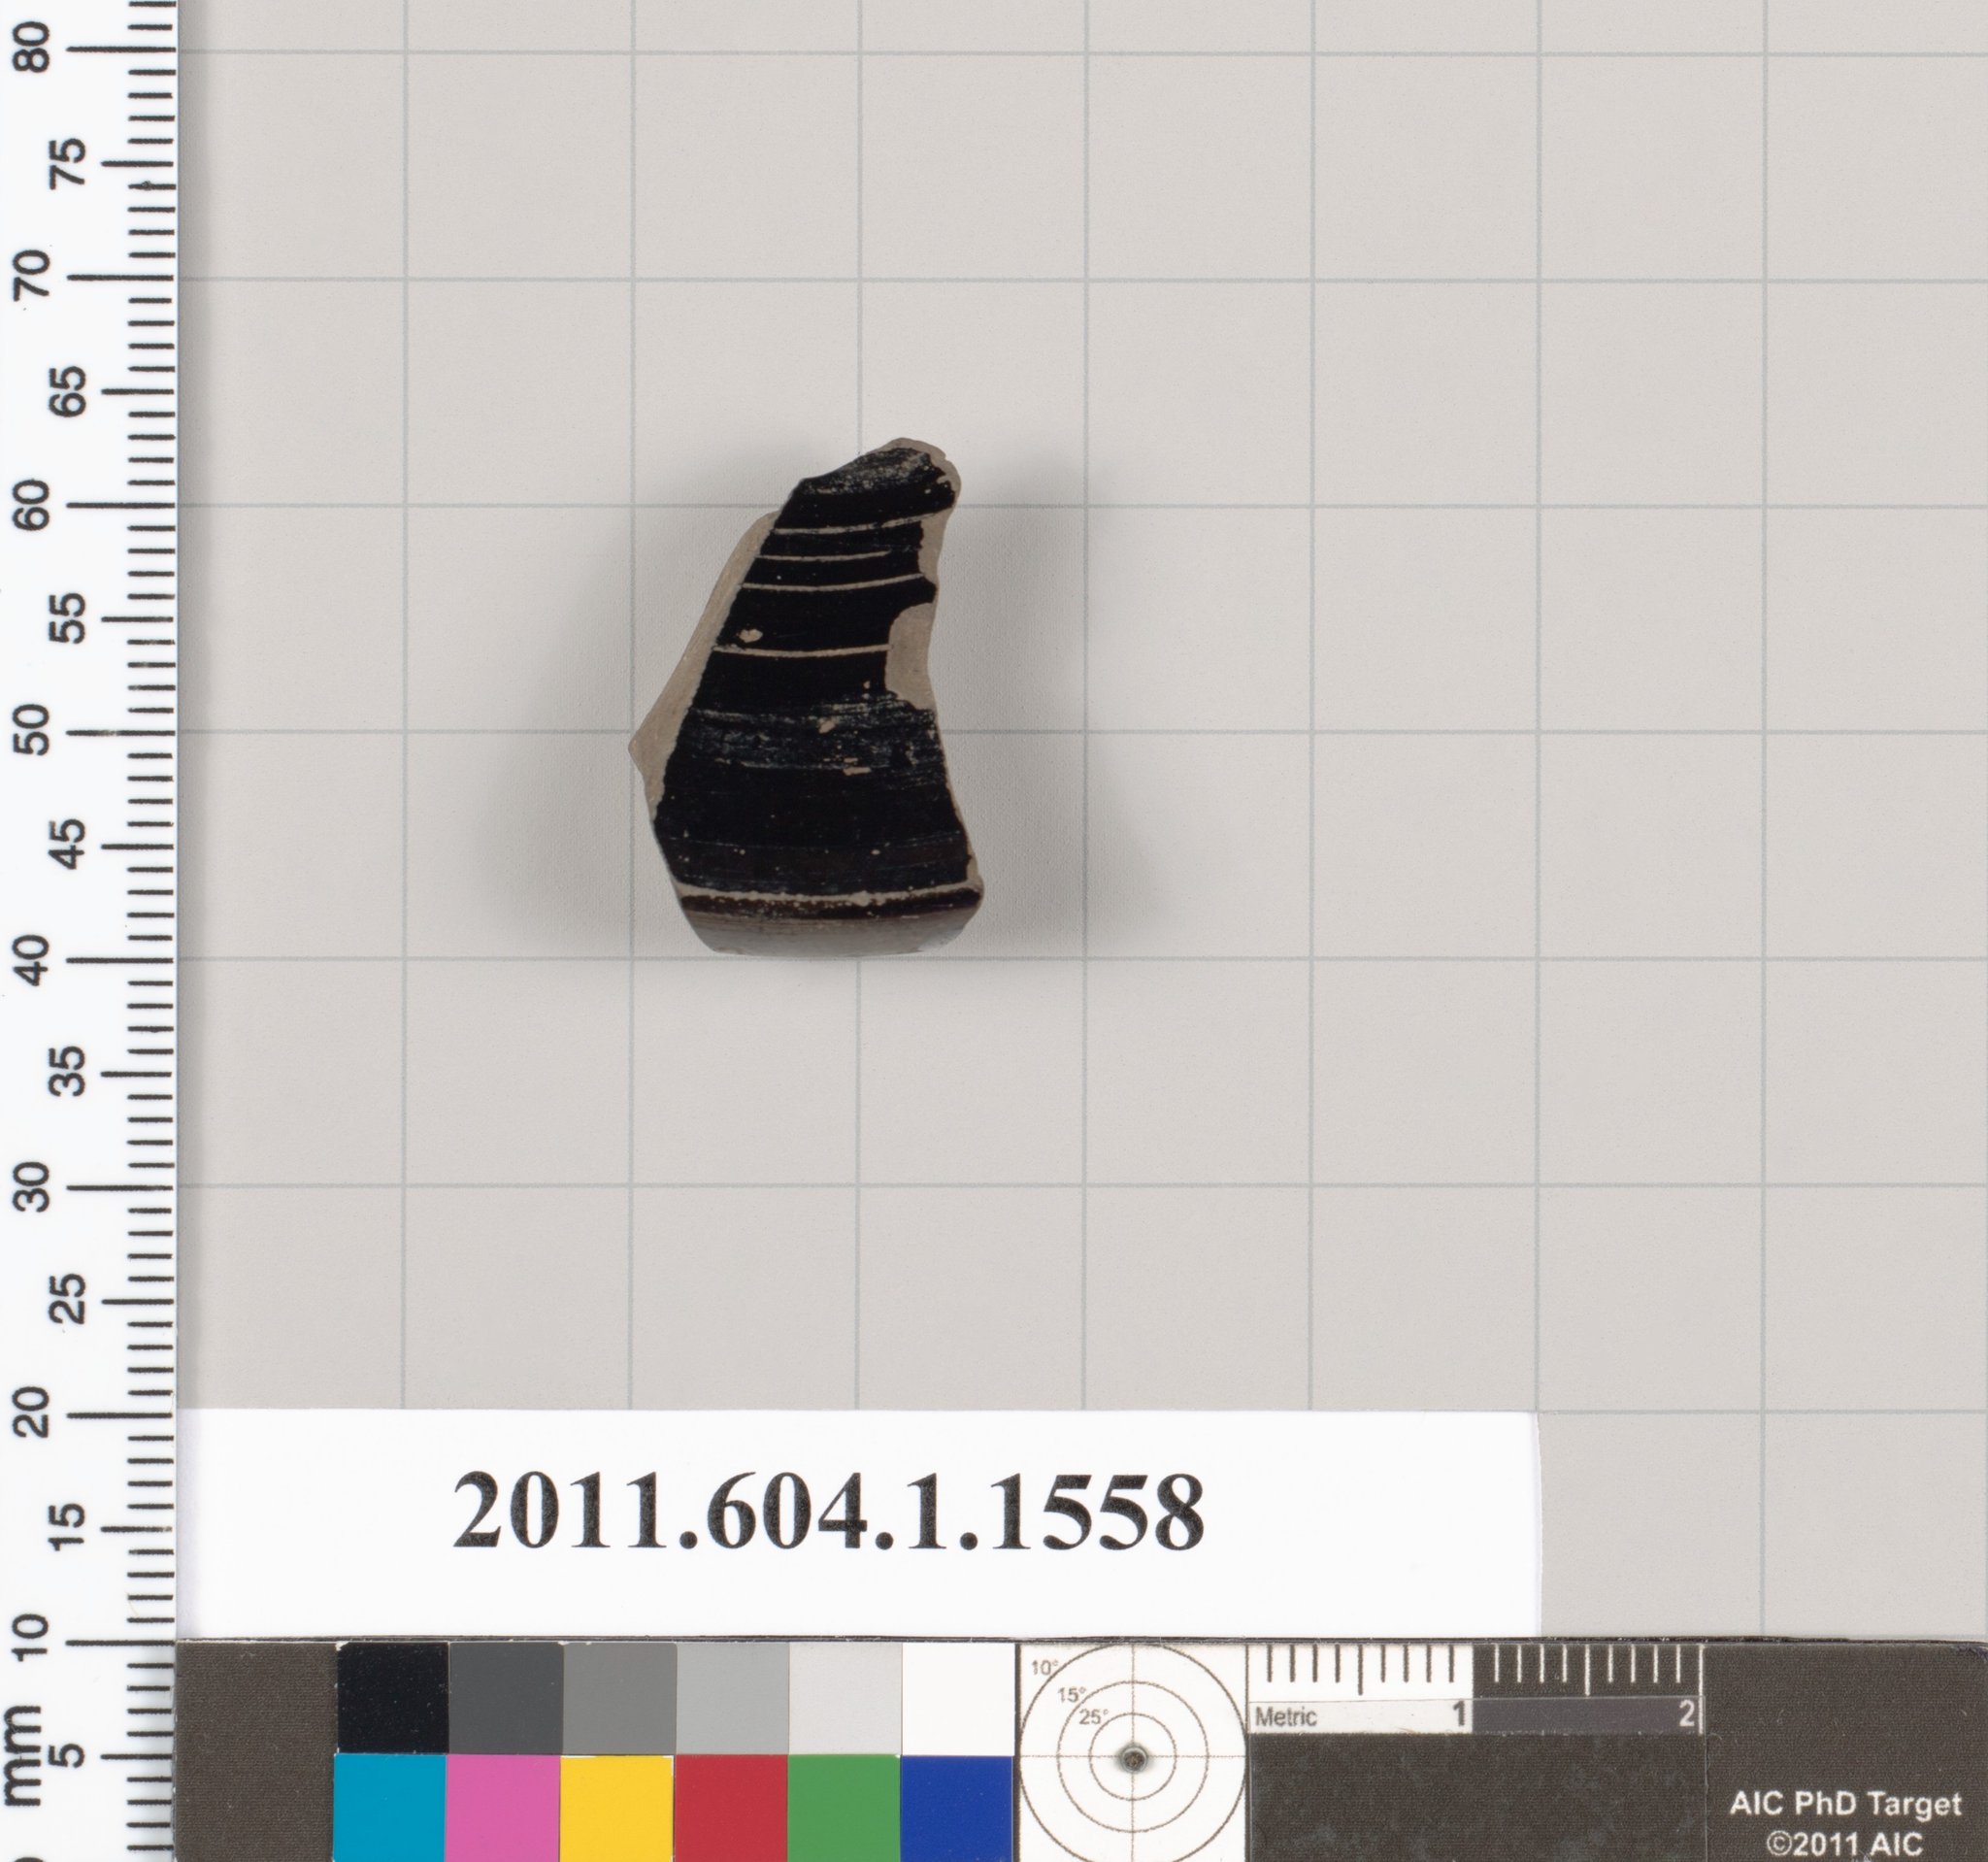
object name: kylix fragment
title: Terracotta fragment of a kylix (drinking cup)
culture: greek, attic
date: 500-401 BCE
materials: terracotta